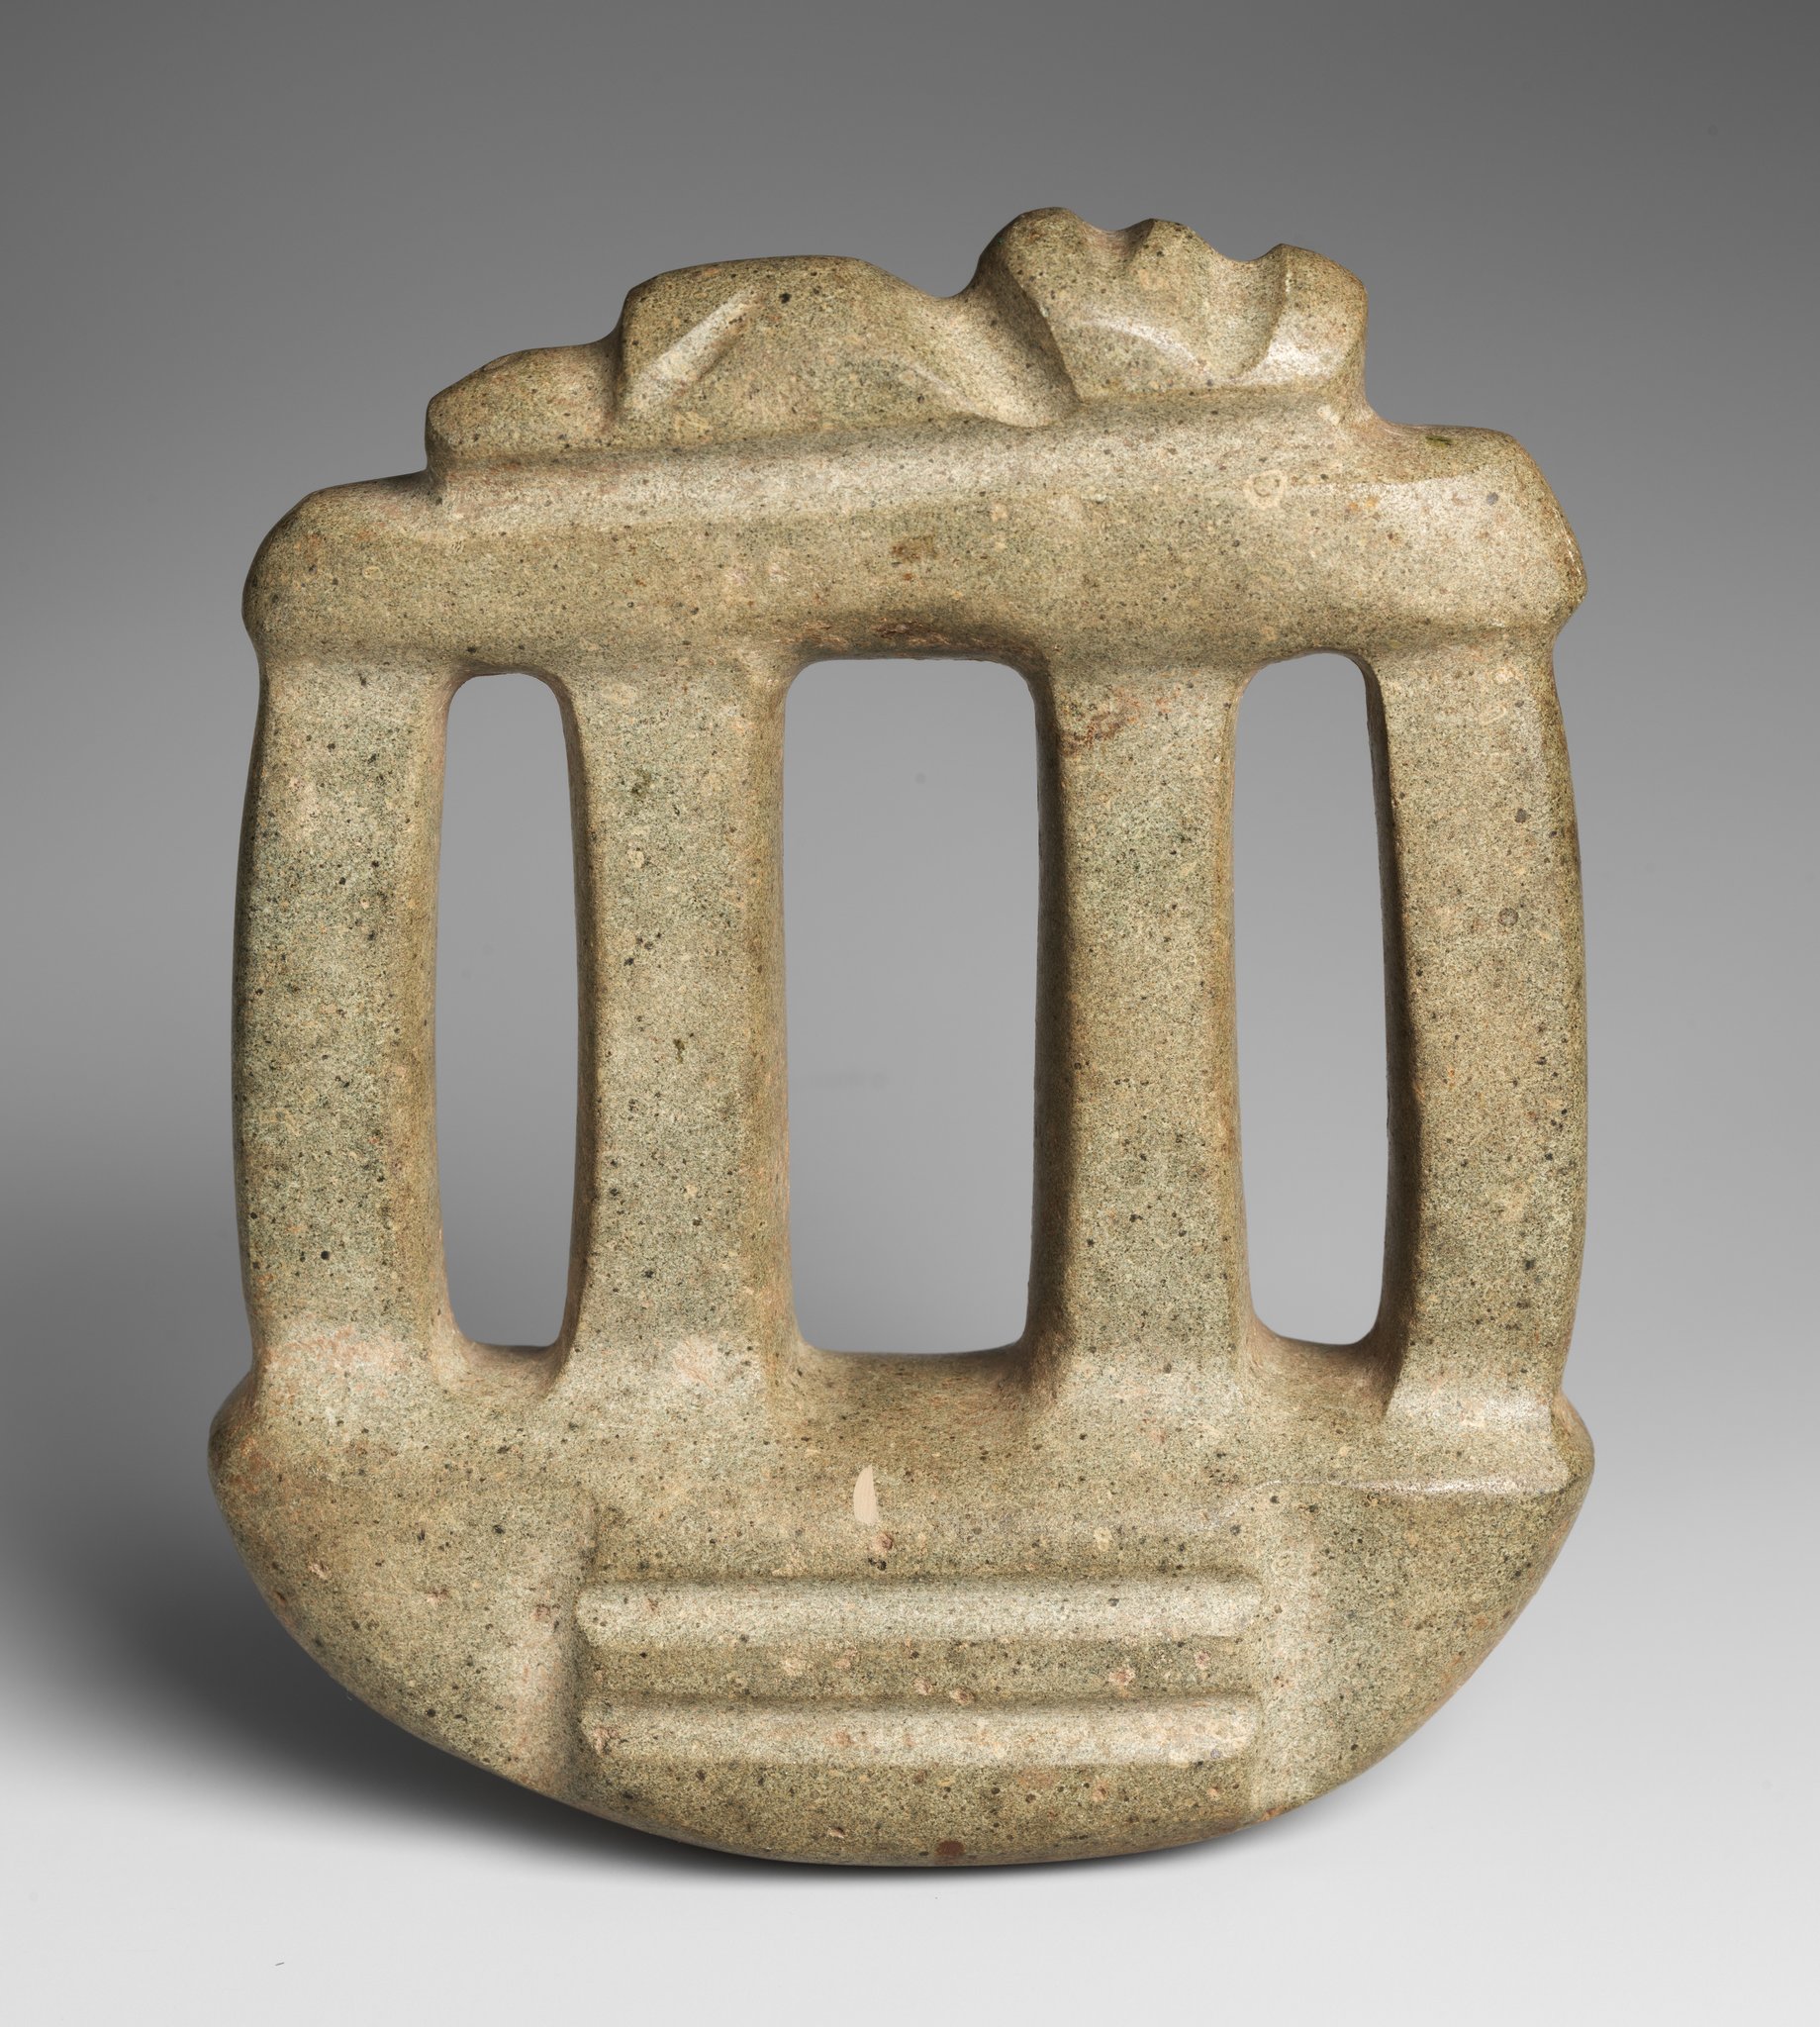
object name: architectural model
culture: mezcala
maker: mezcala artist(s)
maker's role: artist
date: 200 BCE-500 CE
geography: mexico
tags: temples